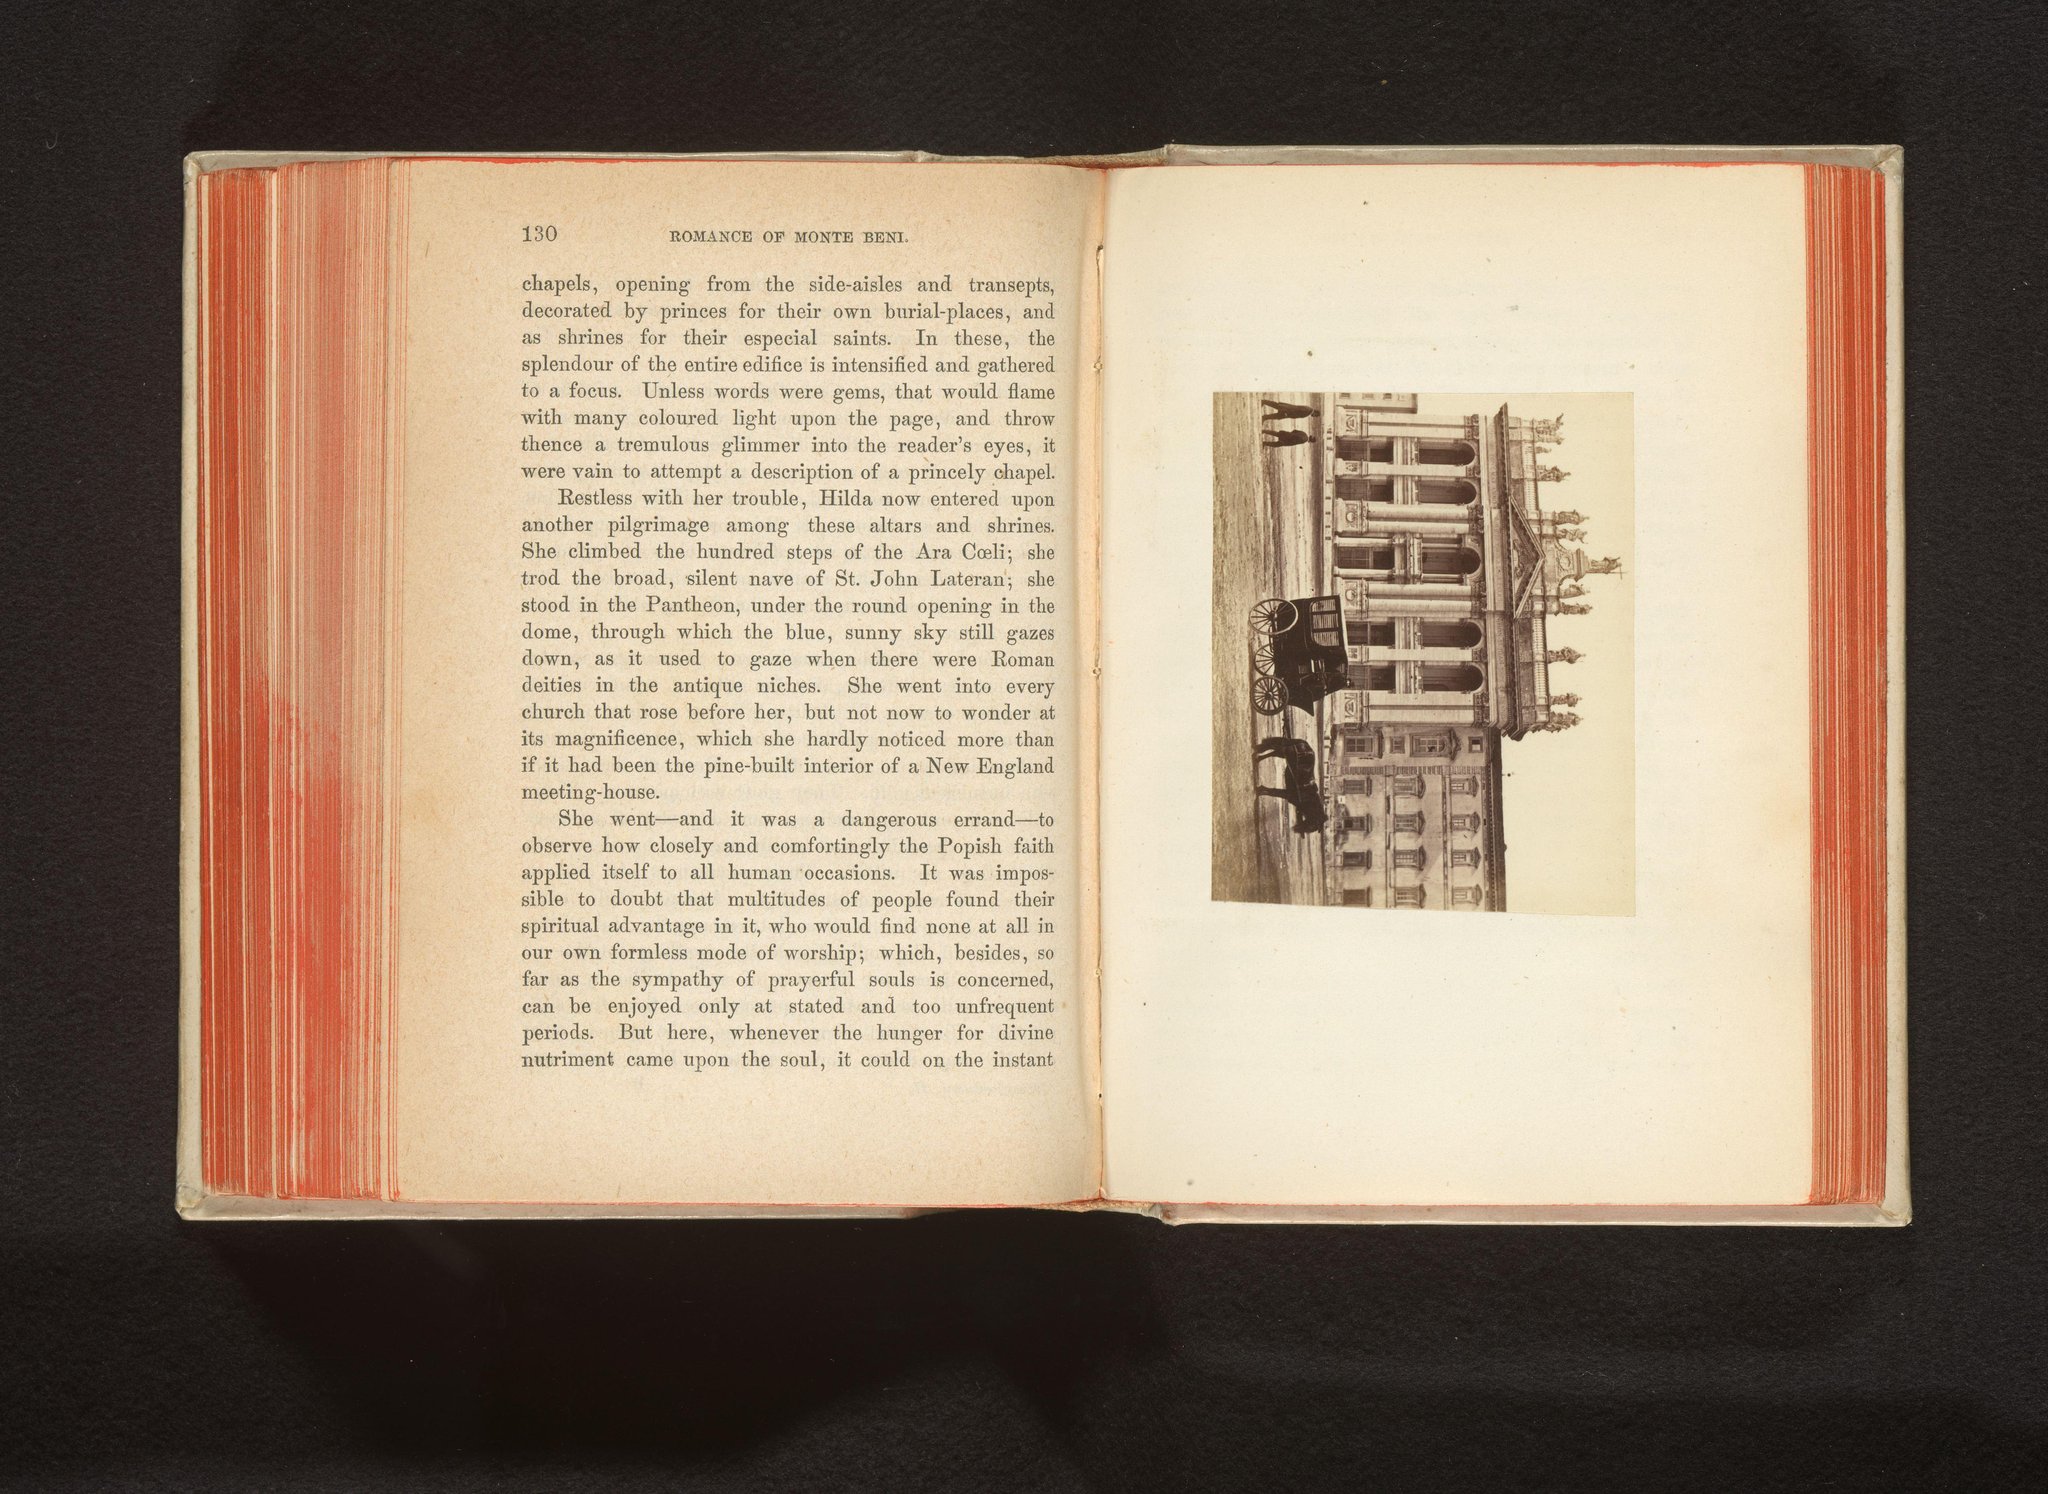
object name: page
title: Gezicht op de Sint-Jan van Lateranen in Rome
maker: Anonymous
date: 1850-1860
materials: photographic support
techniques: albumen print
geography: rome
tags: four-wheeled, animal-drawn vehicle, e.g.: cab, carriage, coach, church (exterior)